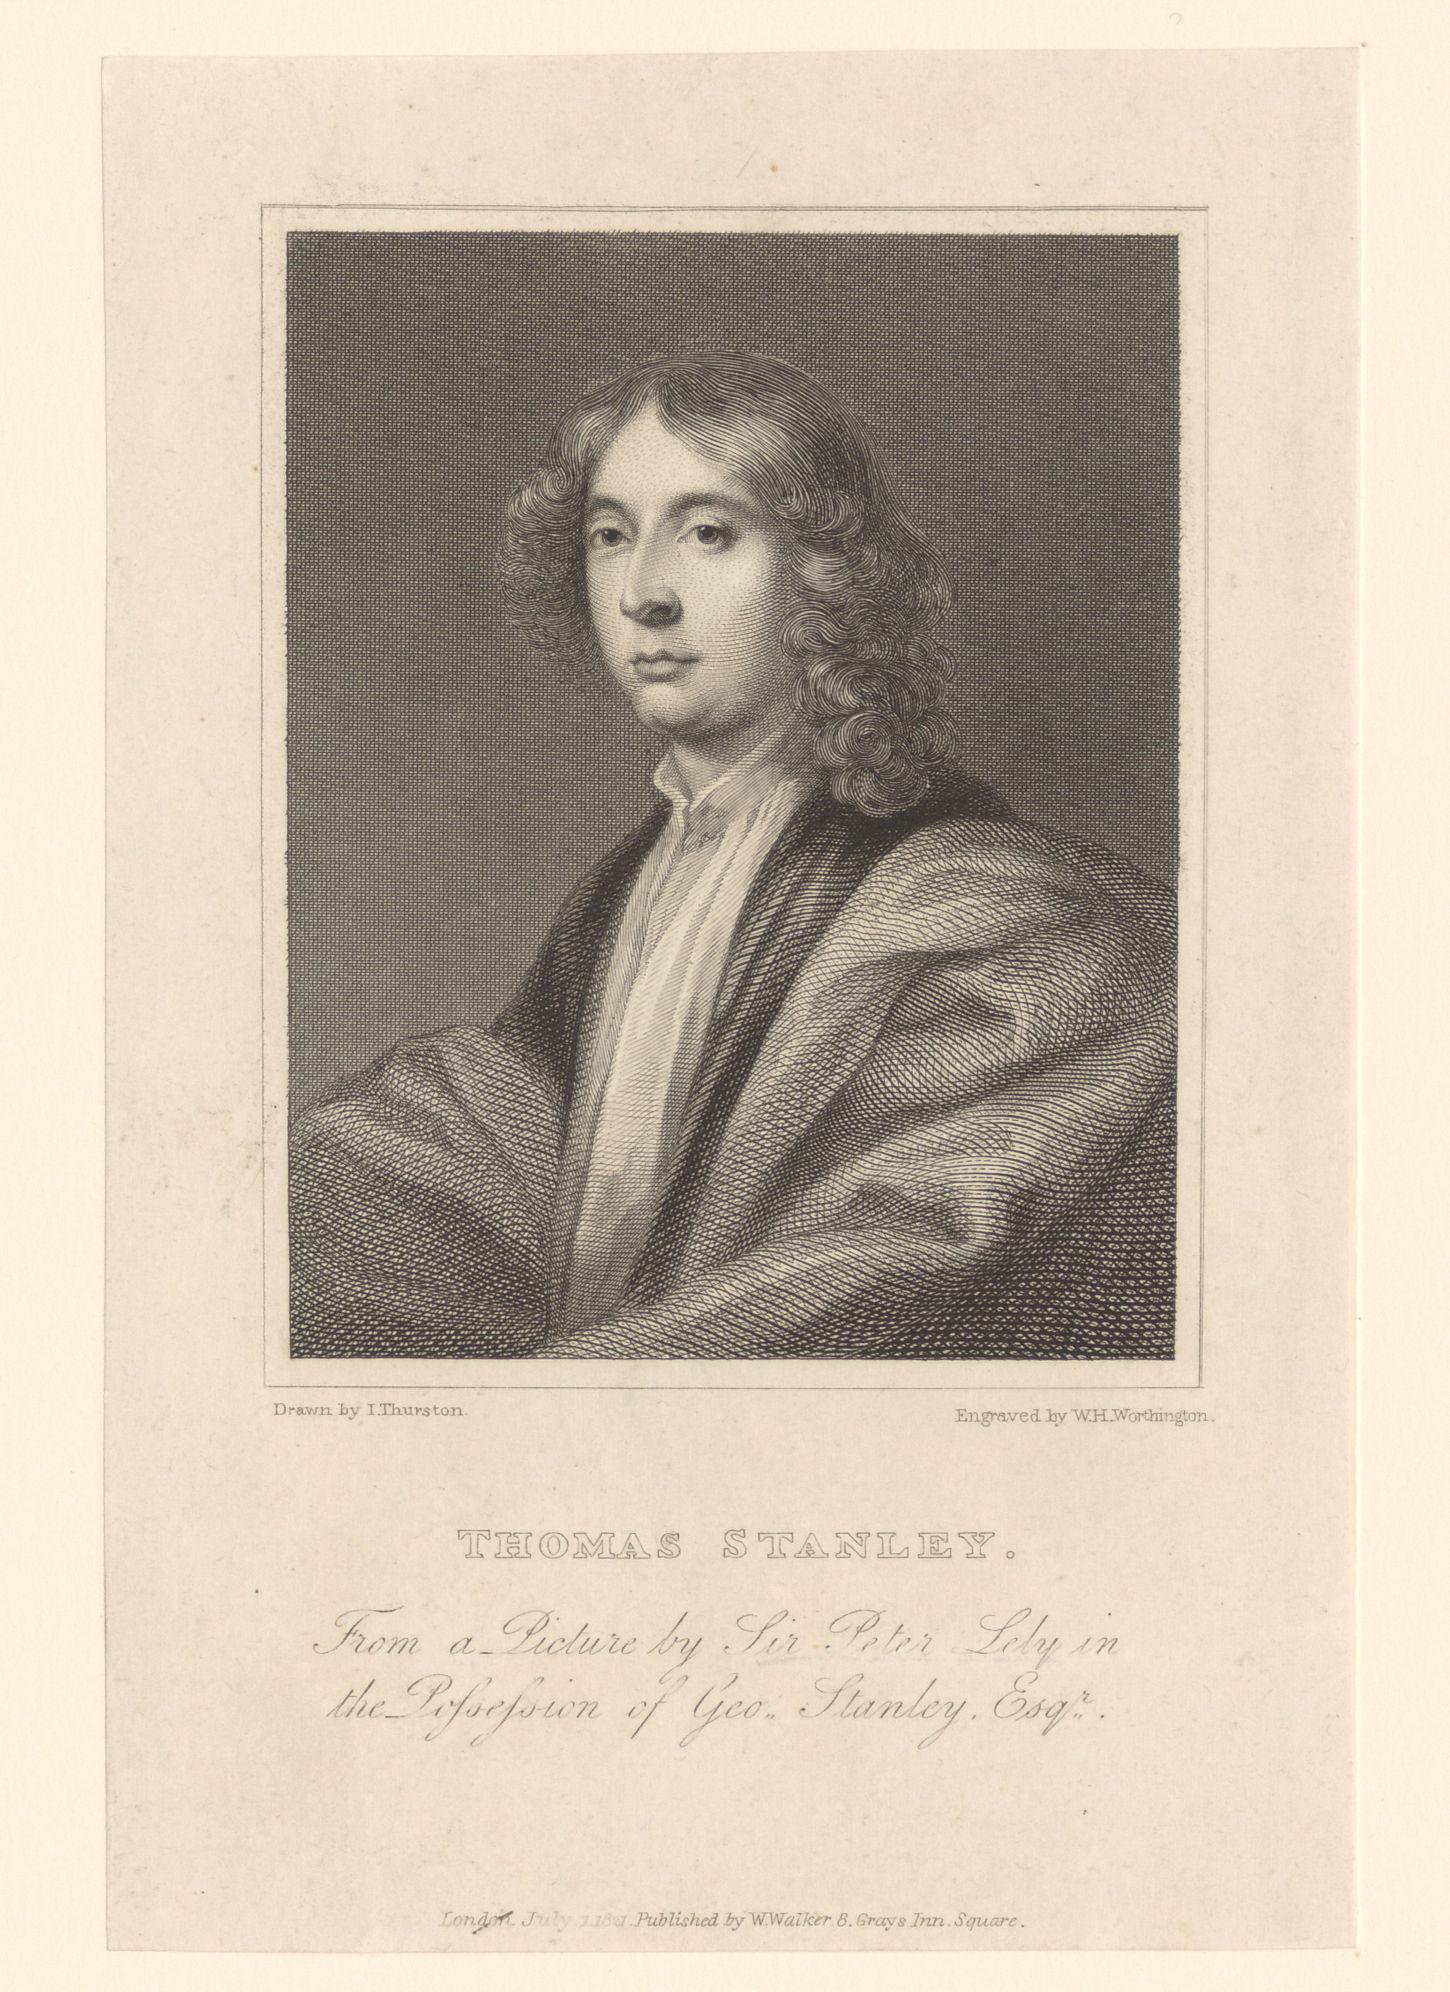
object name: print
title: Portret van Thomas Stanley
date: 1821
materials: paper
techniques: engraving, etching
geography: london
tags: historical persons, portrait of a writer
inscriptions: collector's mark: Lugt 2228